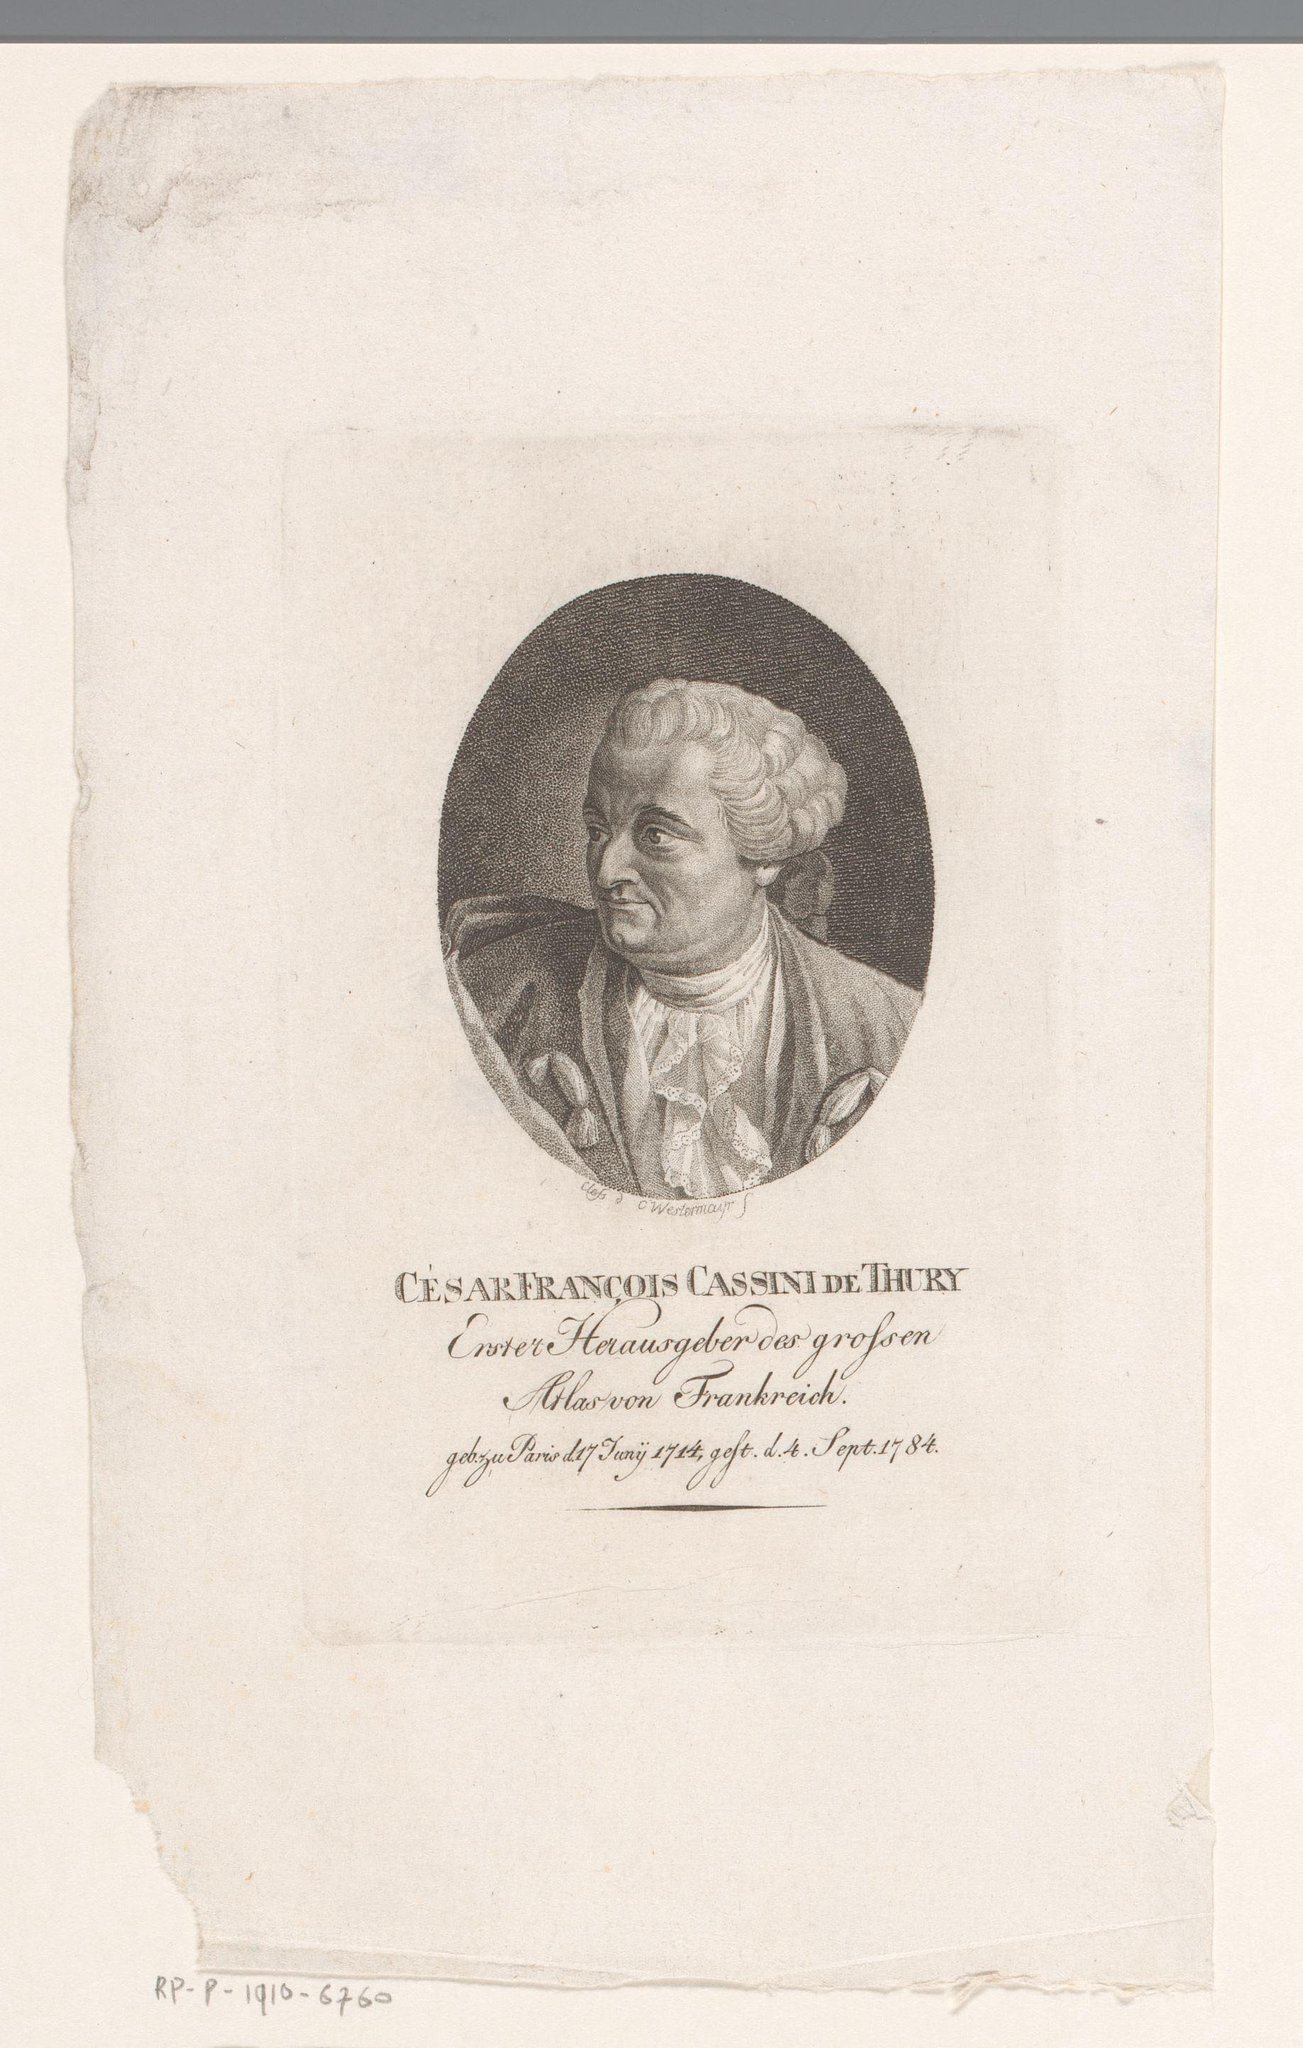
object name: print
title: Portret van César-François Cassini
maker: konrad westermayr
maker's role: print maker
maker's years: 1765-1834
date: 1784-1834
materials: paper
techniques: engraving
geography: germany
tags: paris, historical persons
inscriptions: collector's mark: Lugt 2228